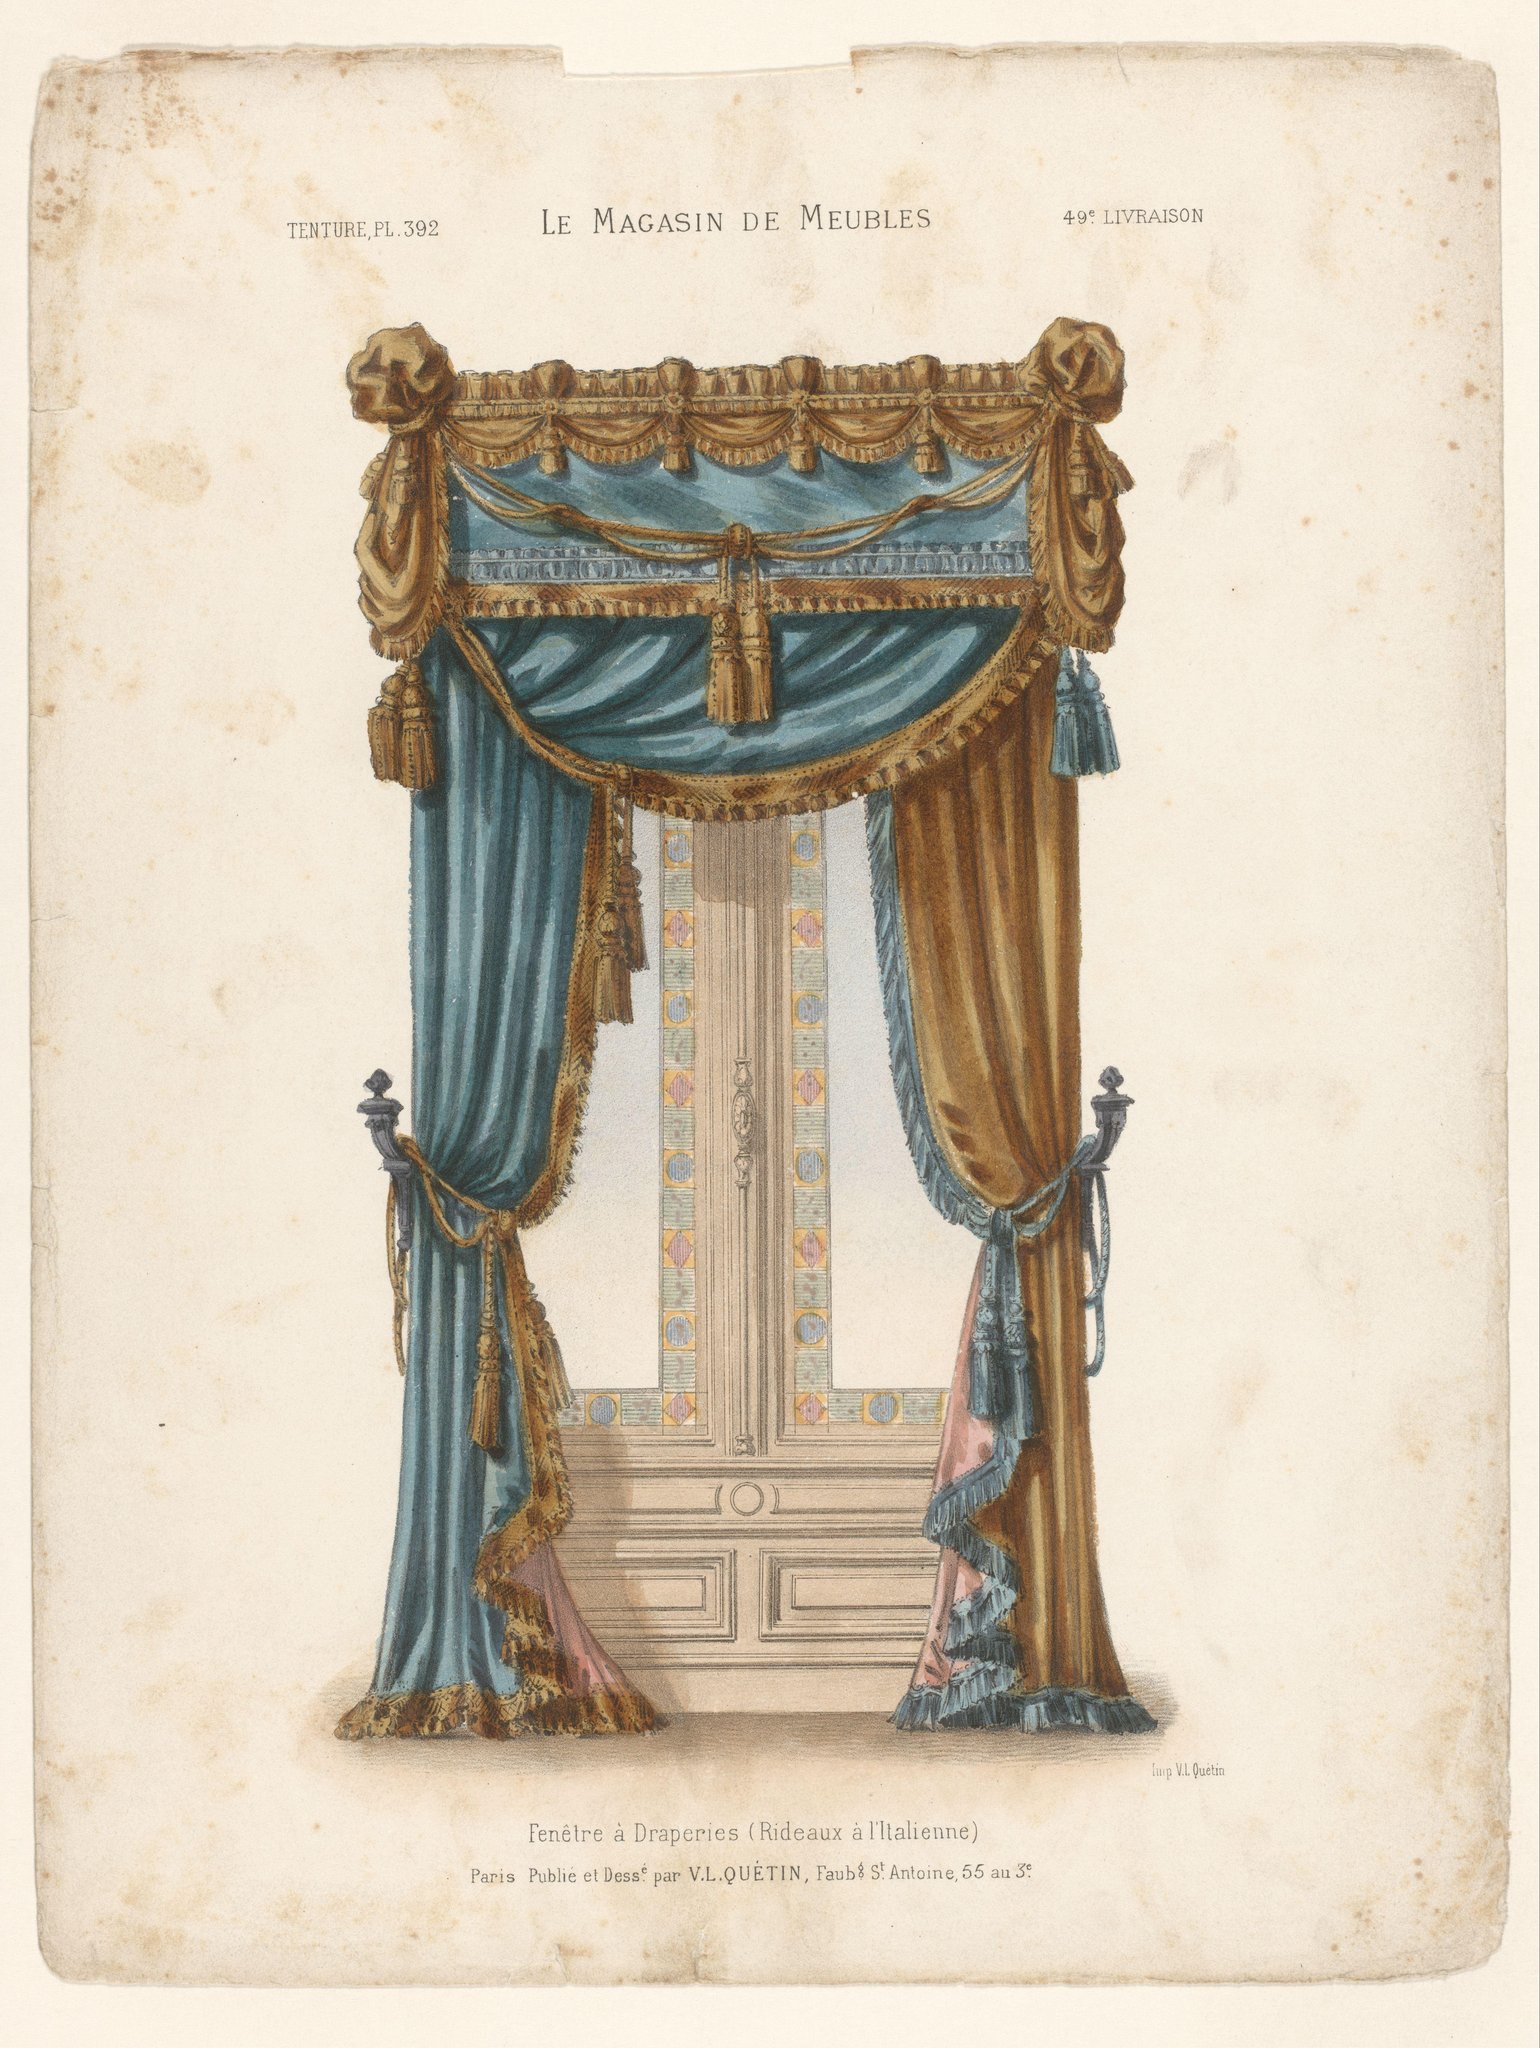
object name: print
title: Fenêtre à Draperies (Rideaux à l'Italienne)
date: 1878-1904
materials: paper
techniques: hand coloring, lithograph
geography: paris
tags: window, hangings and drapery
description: Een venster met gedrapeerde gordijnen. Prent uit 49e Livraison.